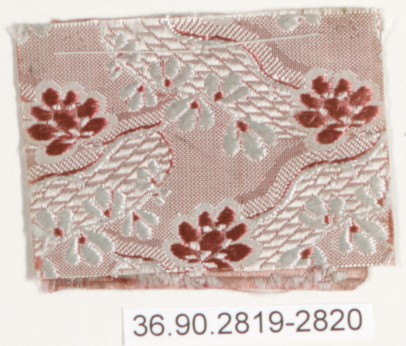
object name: piece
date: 1801-1900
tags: flowers,leaves